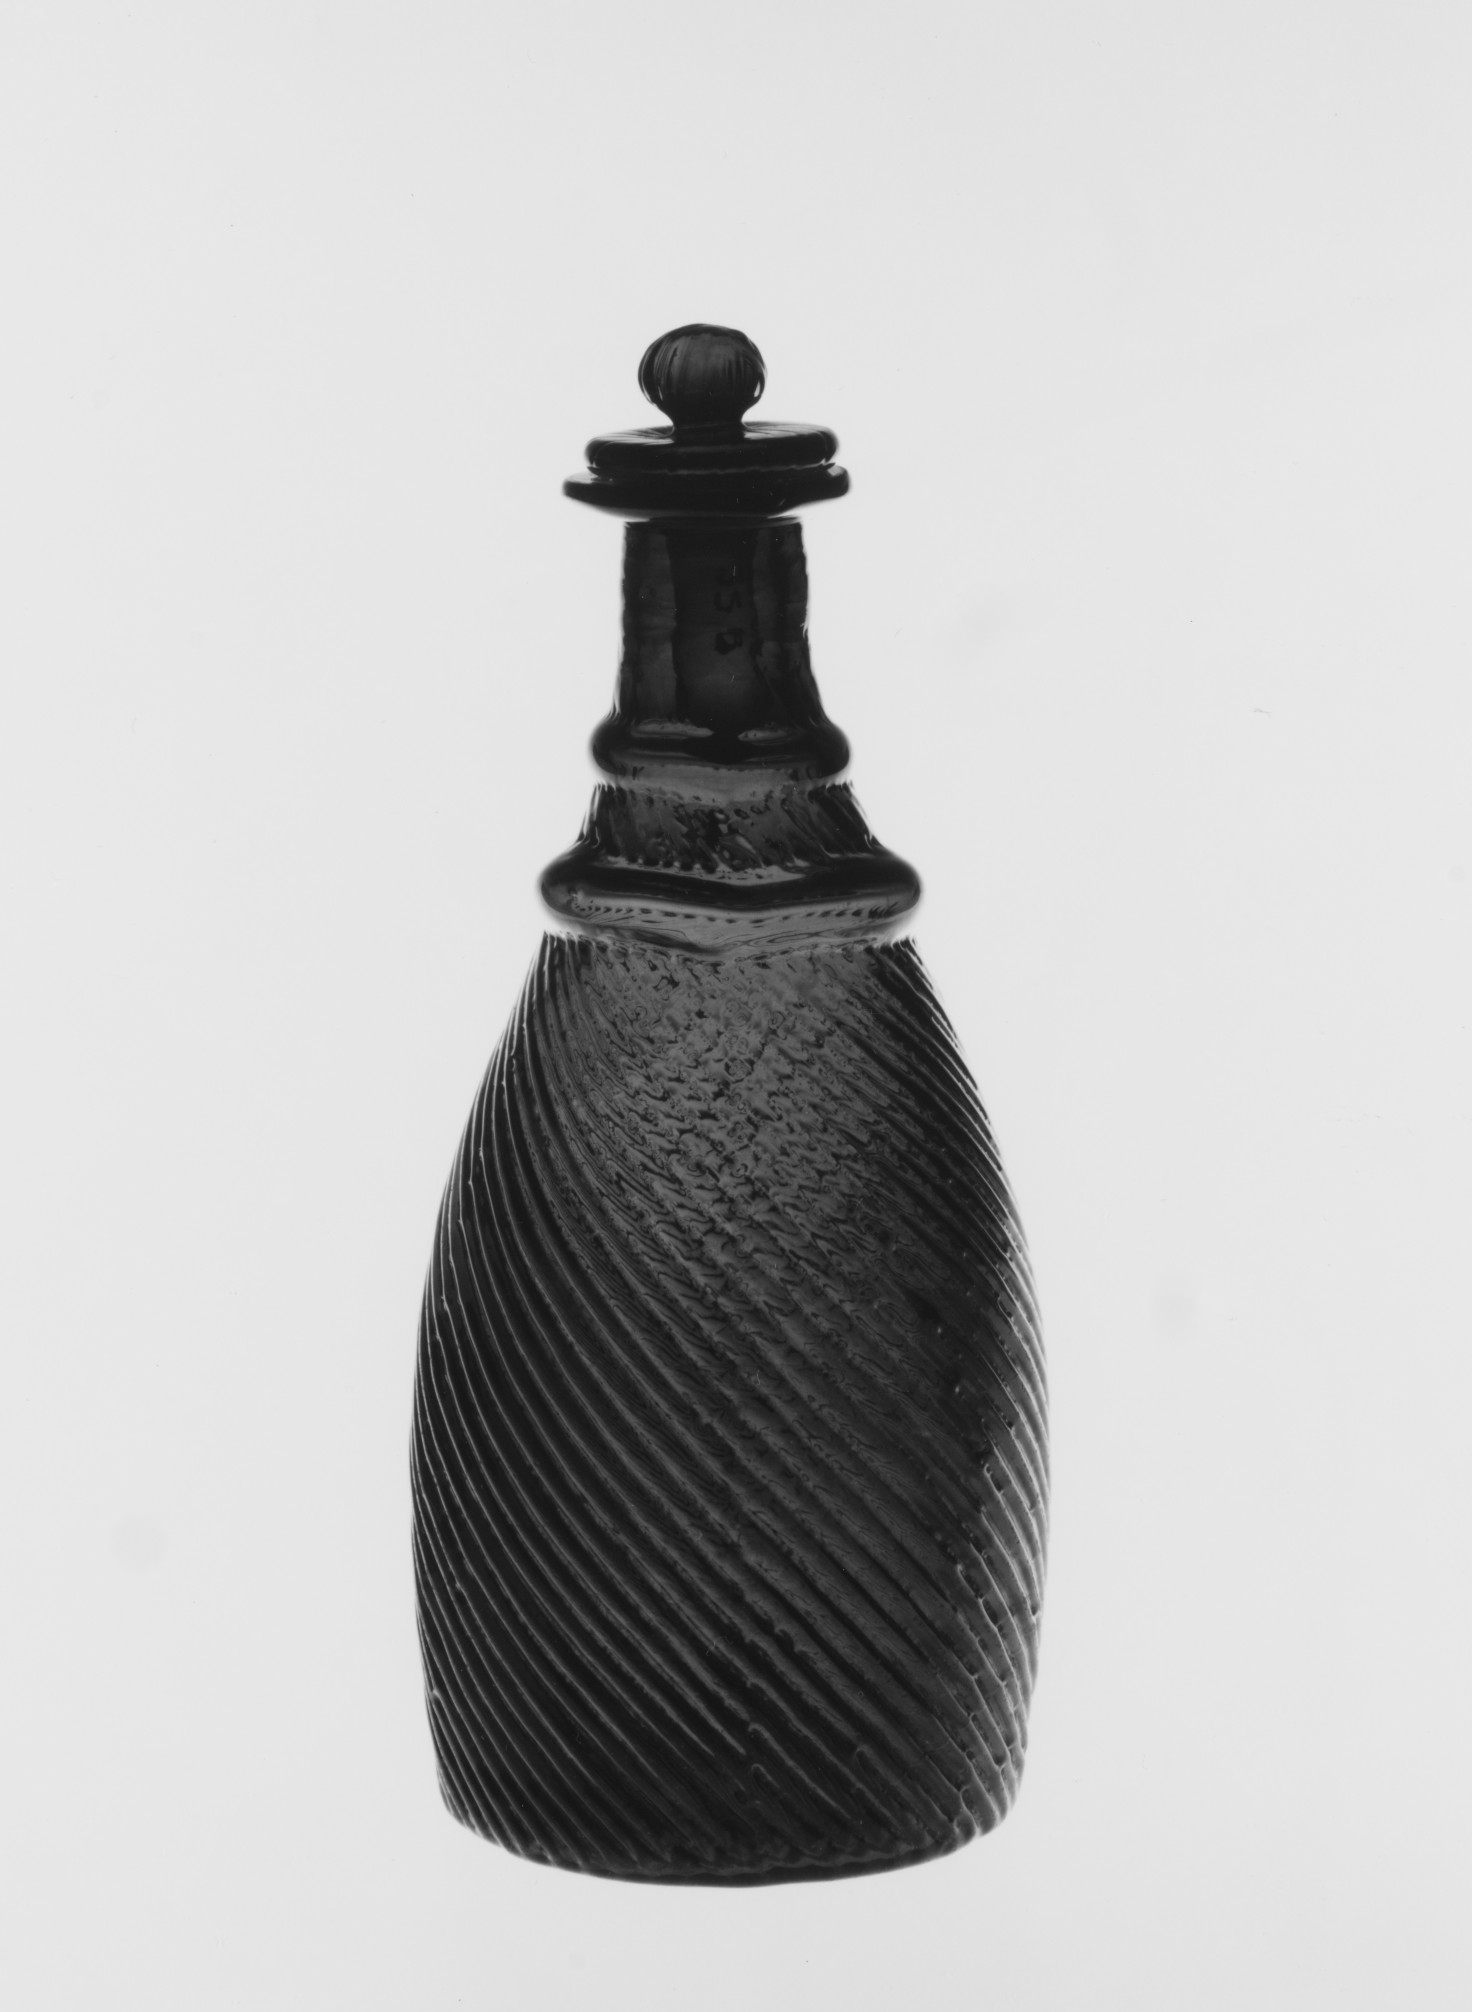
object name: cruet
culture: american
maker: boston & sandwich glass company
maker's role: maker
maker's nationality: american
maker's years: 1825-1888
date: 1825-1892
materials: glass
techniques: glassblowing, molding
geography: united states